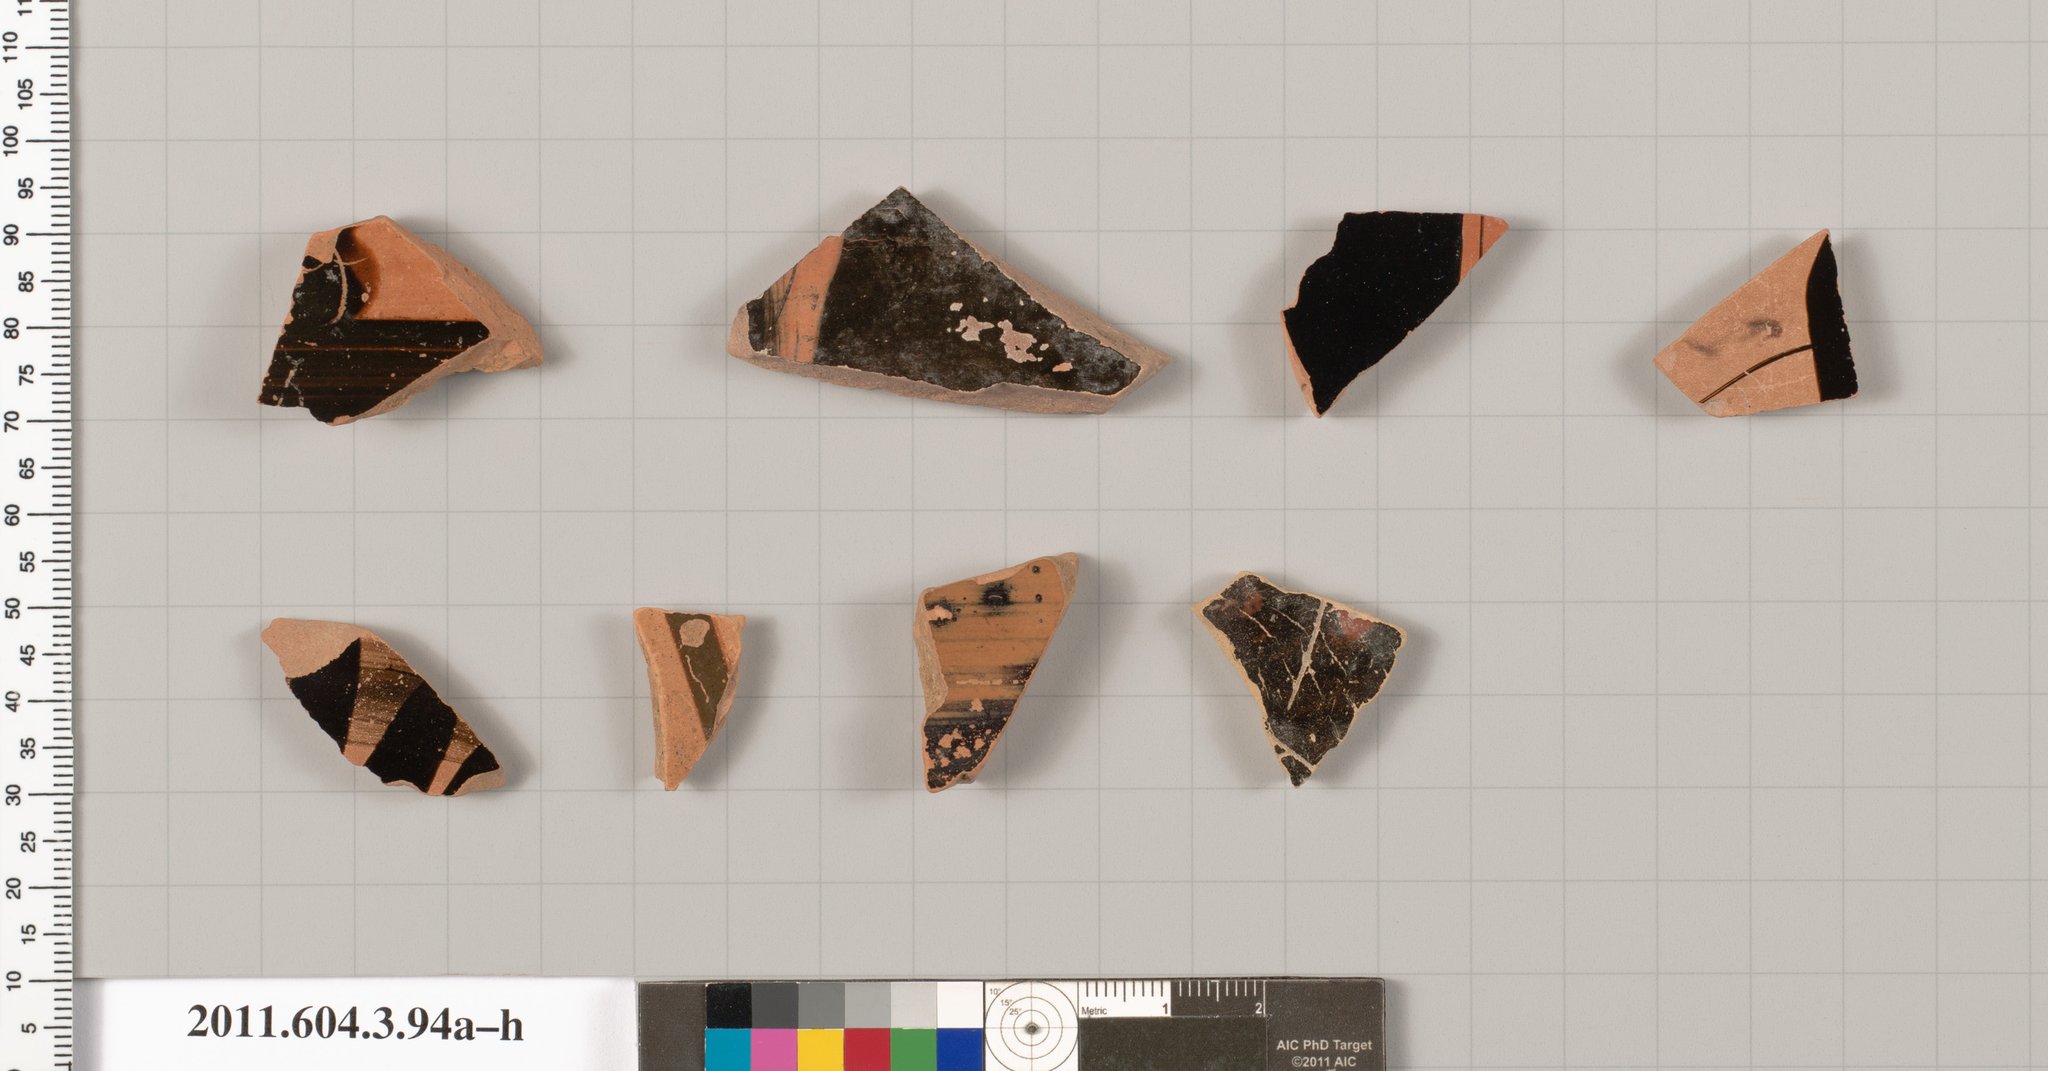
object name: amphora fragment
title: Terracotta fragments of amphorae (jars)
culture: greek, attic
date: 550-501 BCE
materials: terracotta